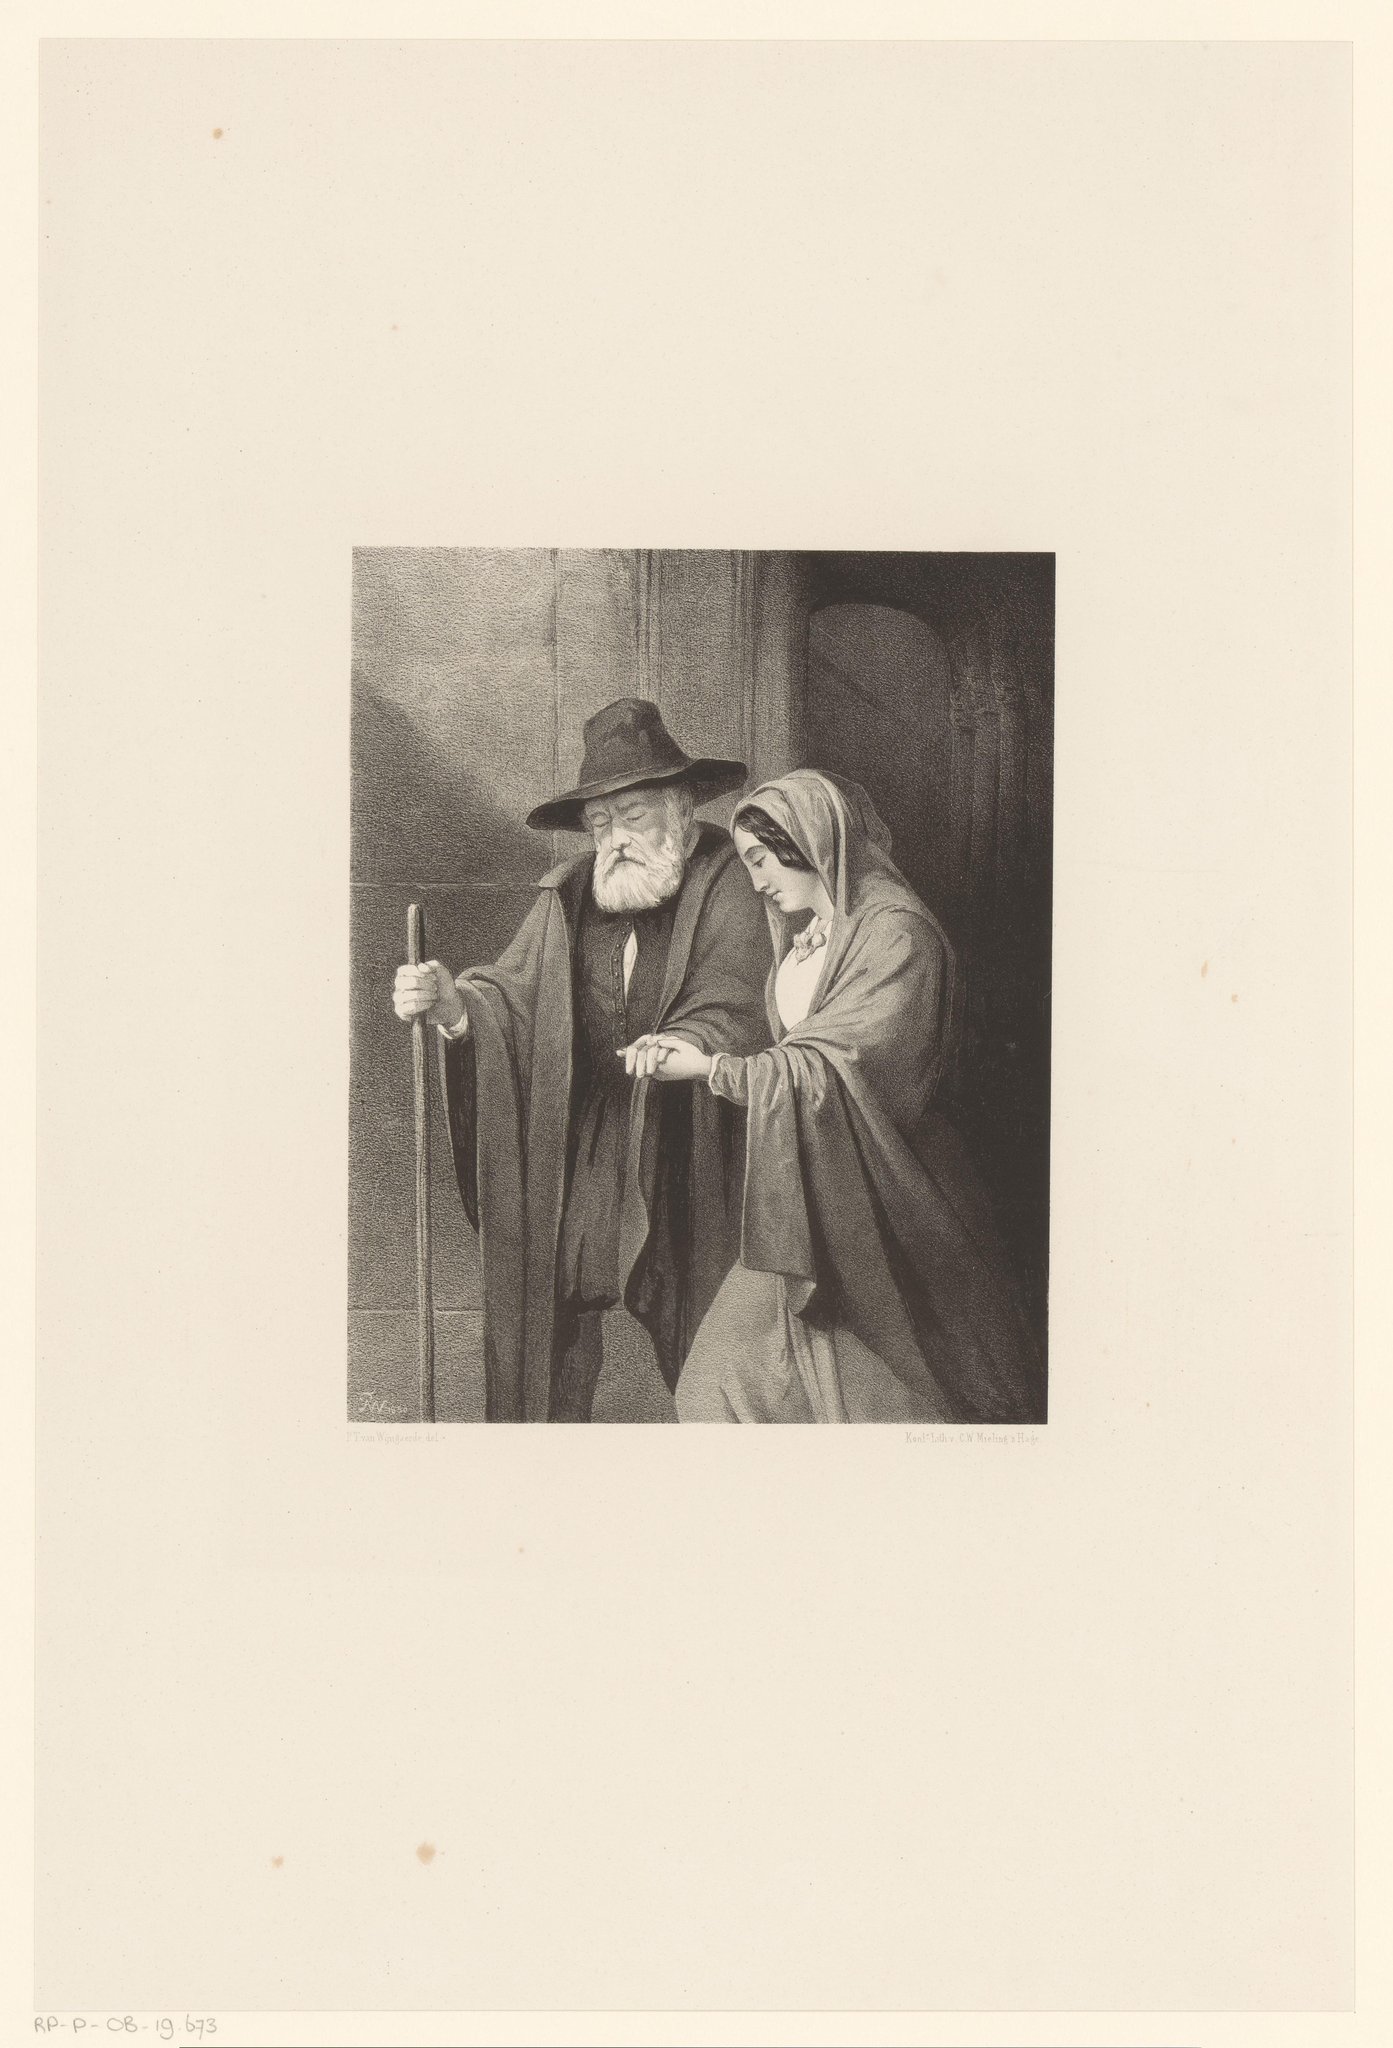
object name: print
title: Vrouw begeleidt een blinde man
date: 1850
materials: paper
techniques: lithograph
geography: the hague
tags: blind, blindness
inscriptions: collector's mark: Lugt 2228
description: Een jonge vrouw begeleidt een blinde oude man met stok.